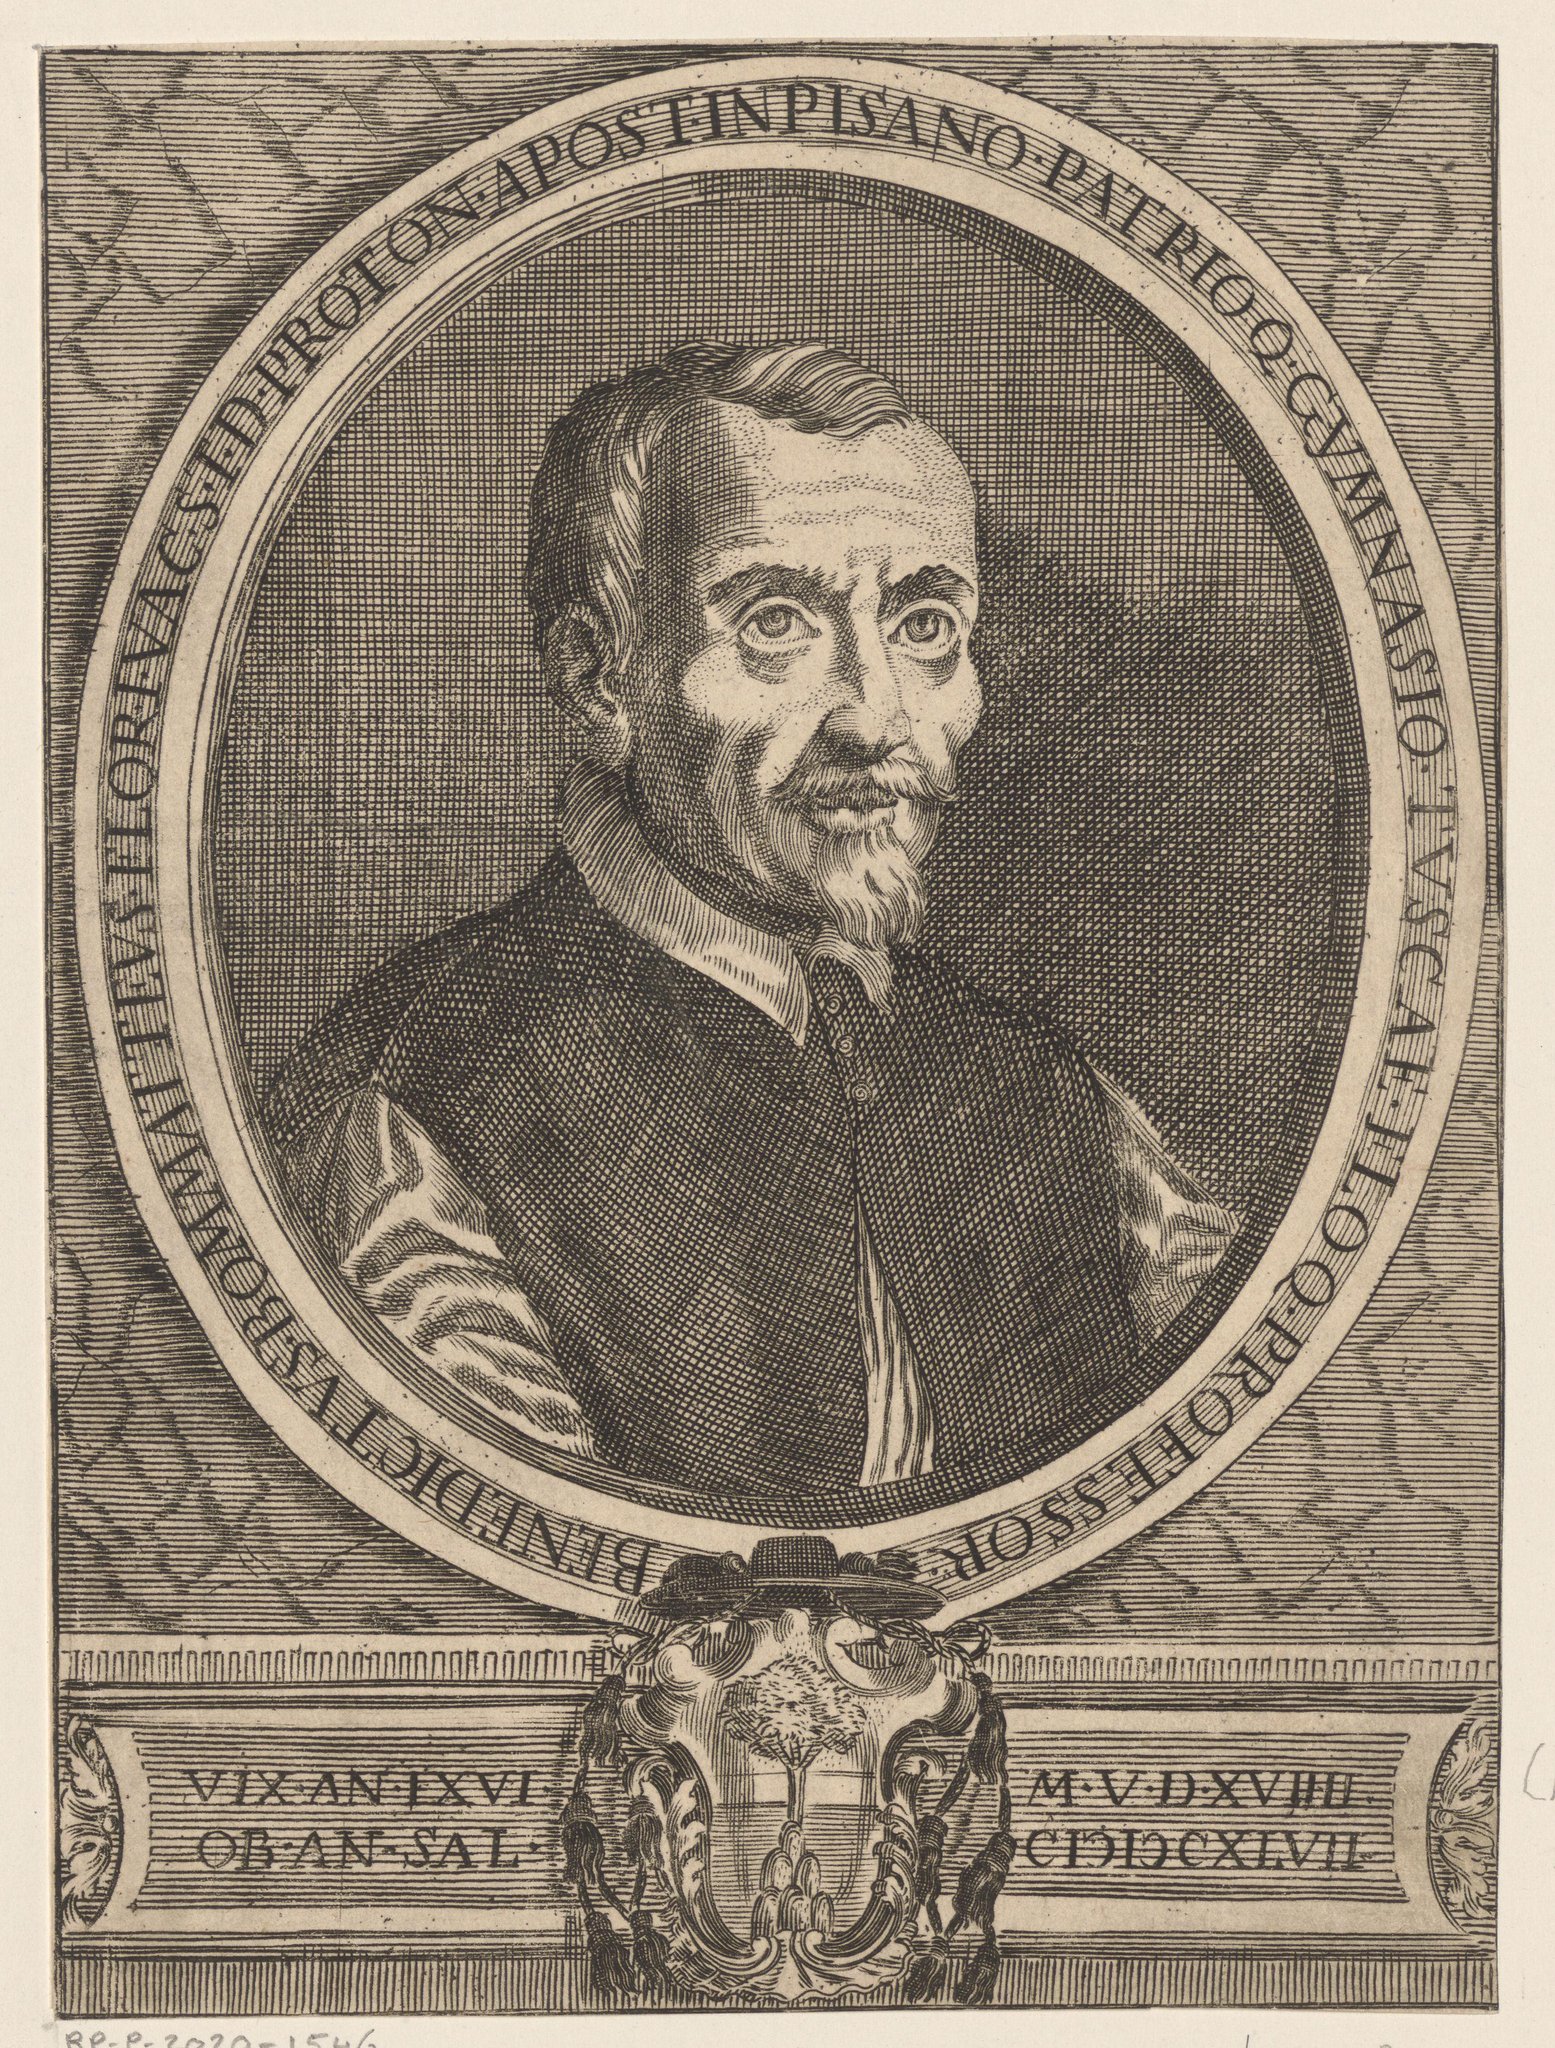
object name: print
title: Portret van Benedetto Buommattei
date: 1700-1749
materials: paper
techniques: engraving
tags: historical persons, portrait of a writer, armorial bearing, heraldry